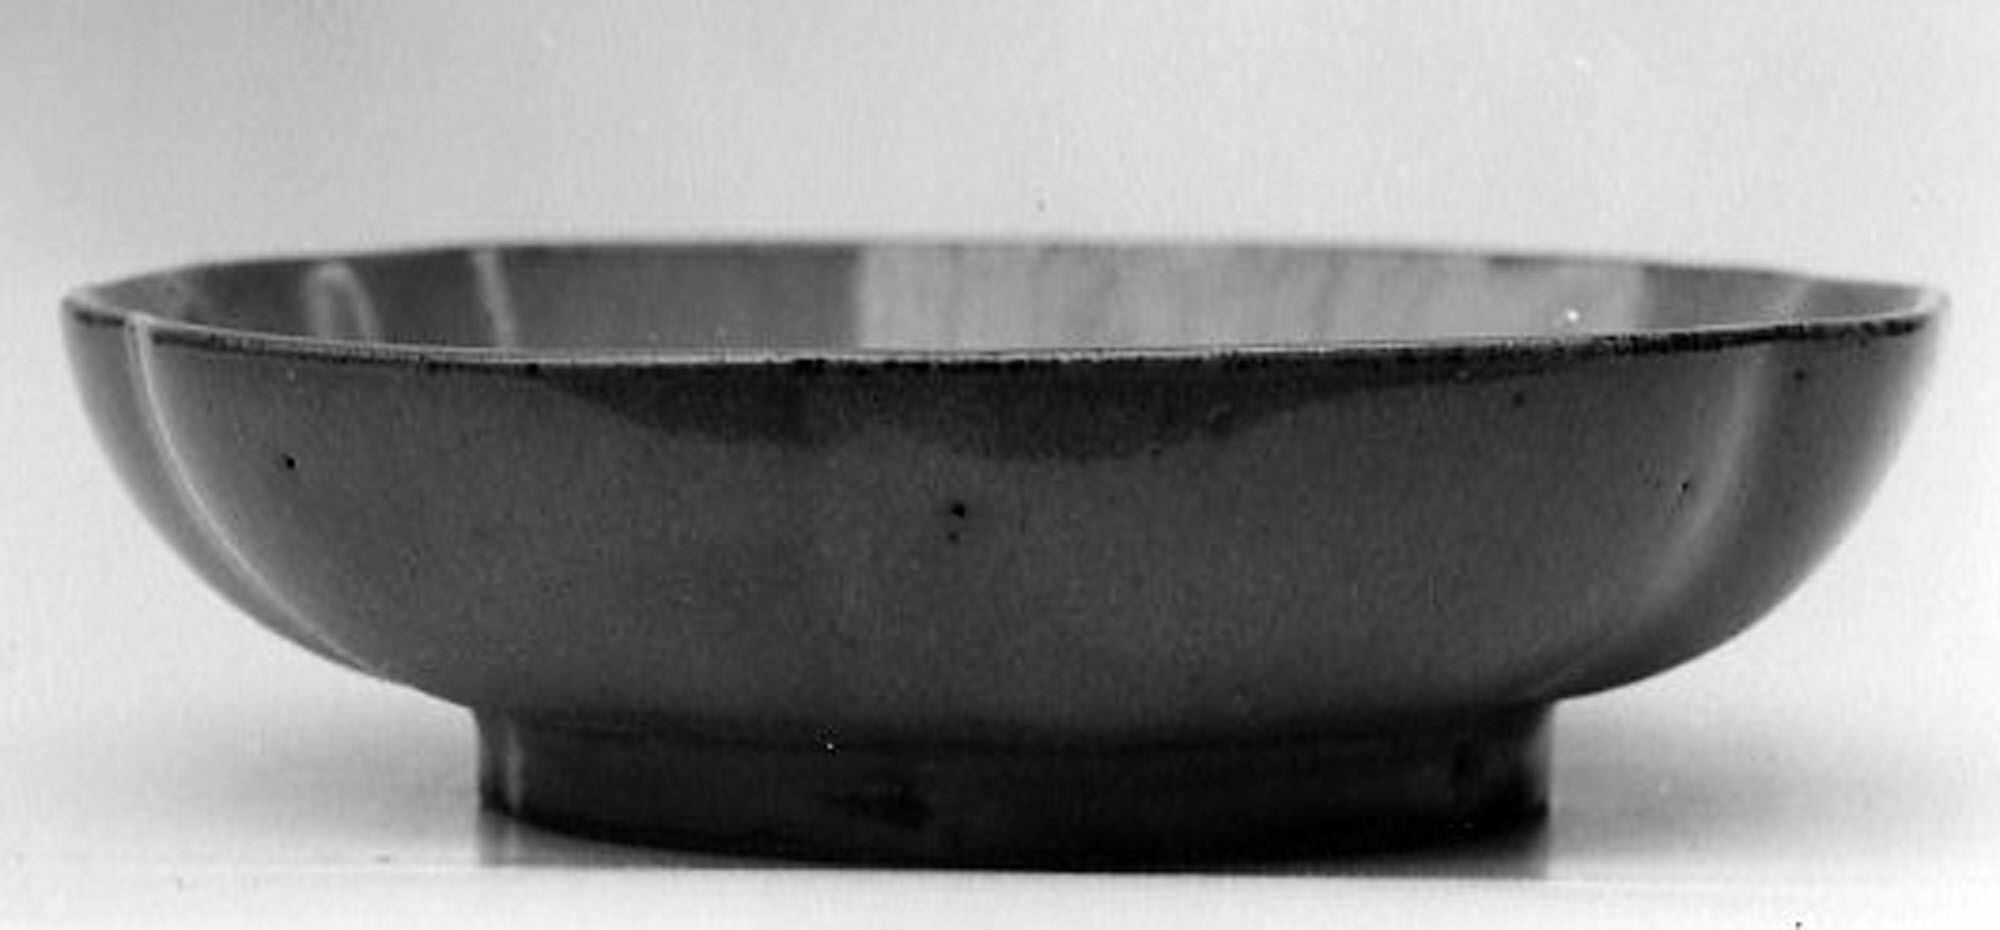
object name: dish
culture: chinese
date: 1723-1736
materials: pottery